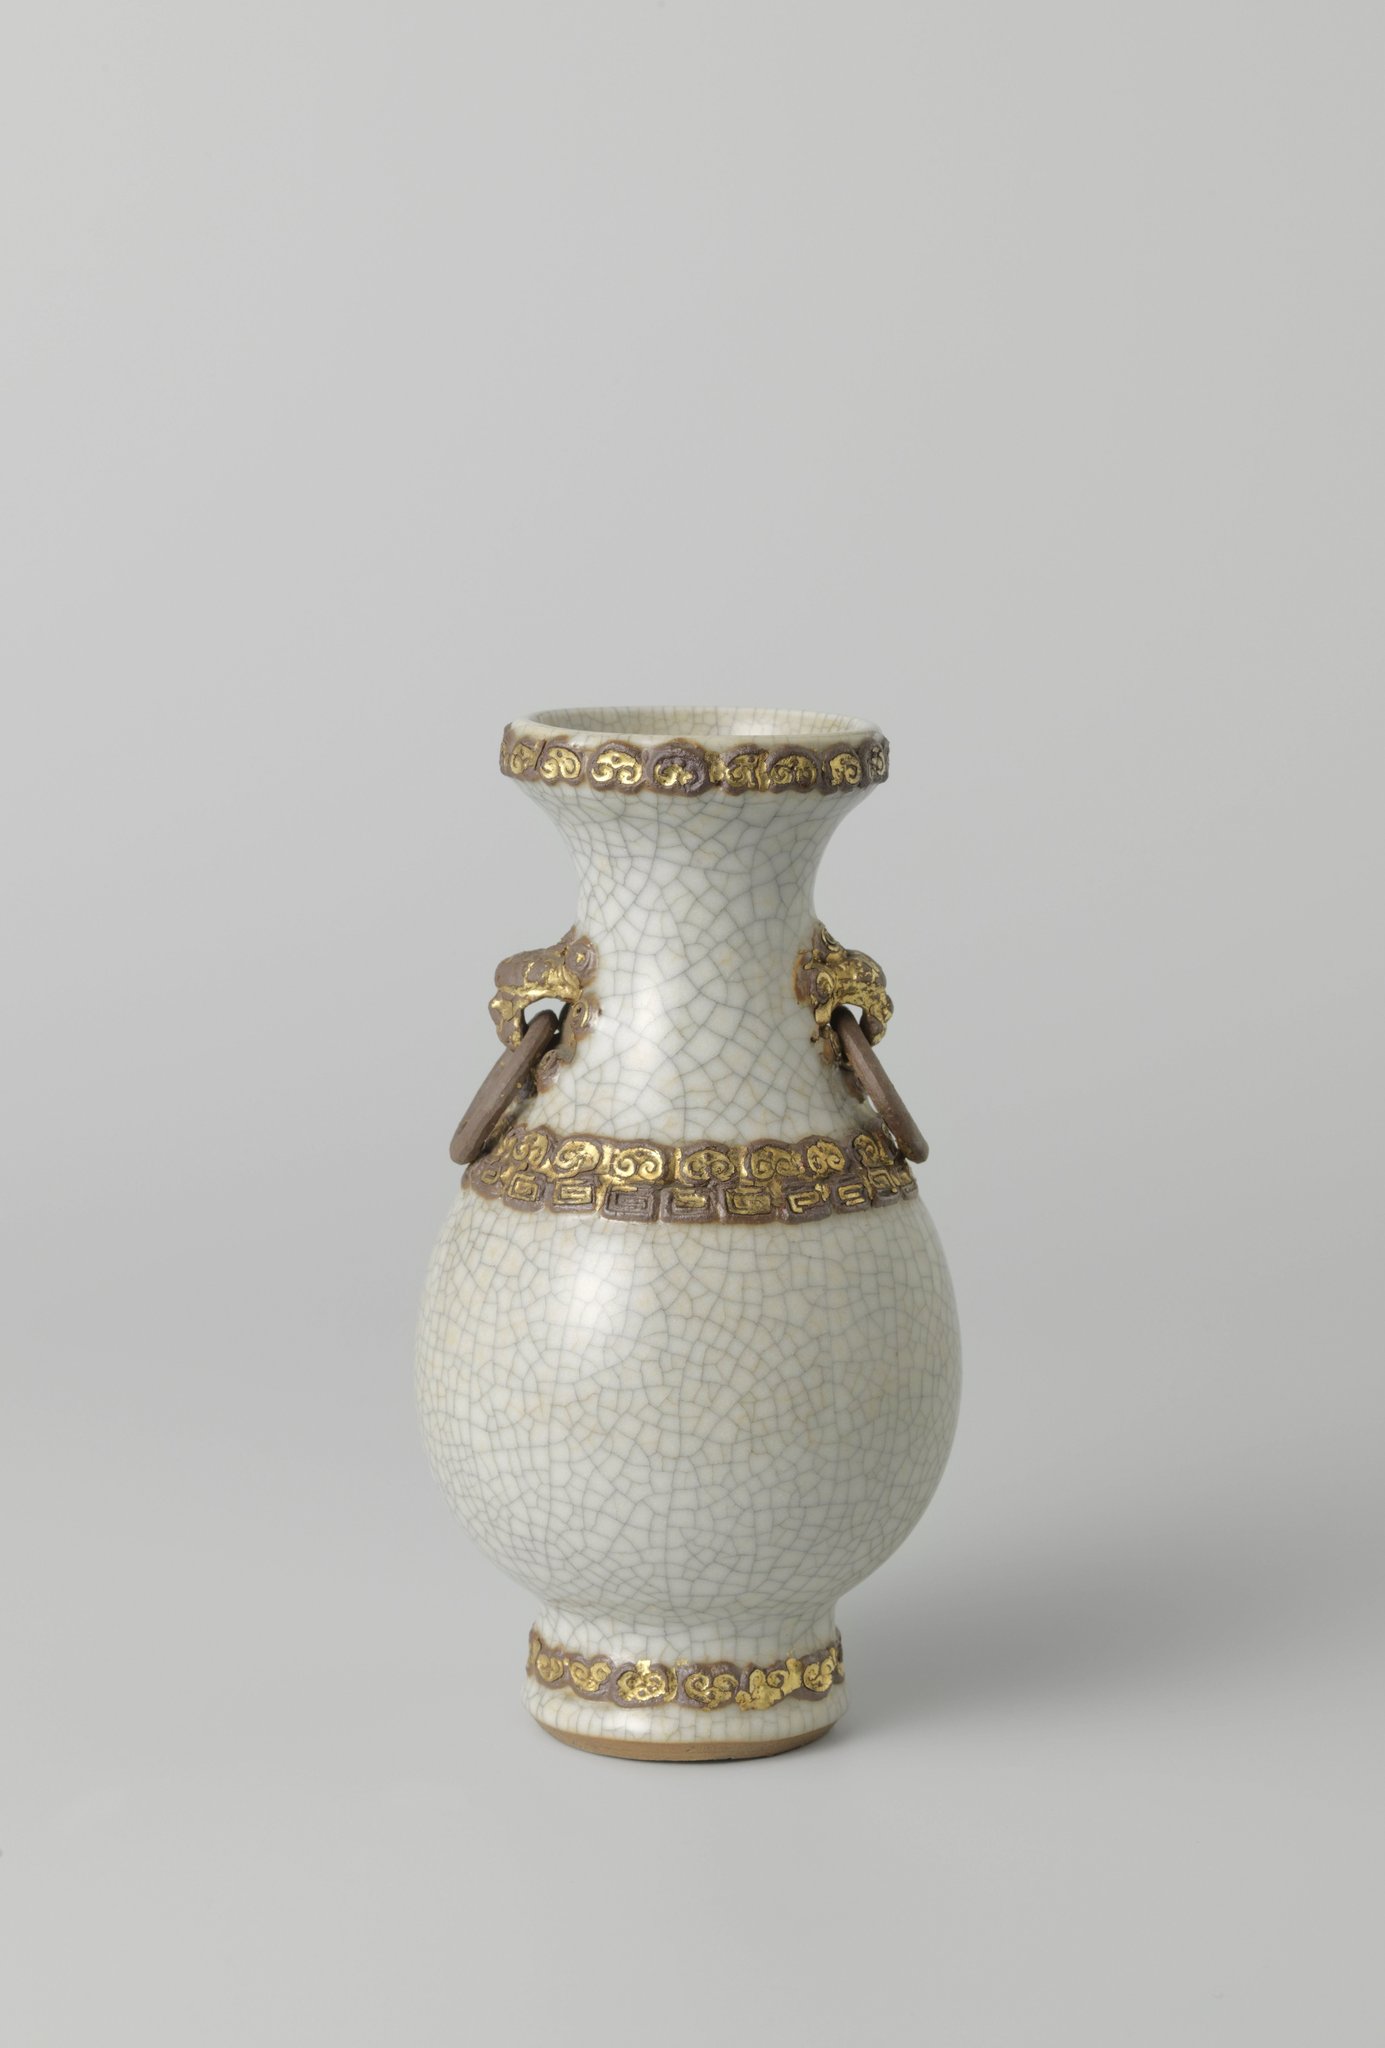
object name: vase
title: Pear-shaped vase with monster heads and gilded bands with ruyi motif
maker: Anonymous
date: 1750-1799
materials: glaze, gold, porcelain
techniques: firing, forming, gilding, turning, vitrification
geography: china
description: Peervormige vaas van porselein met uitlopende nek en opstaande rand, bedekt met een monochroom gecraqueleerd grijs glazuur en op biscuit goud. Aan weerszijden op de schouder een monsterkop met ring; rond de voet, schouder en nek een band met ruyi-motief, decoratie in verguld biscuit. Vergulding schilfert. Monochromen.